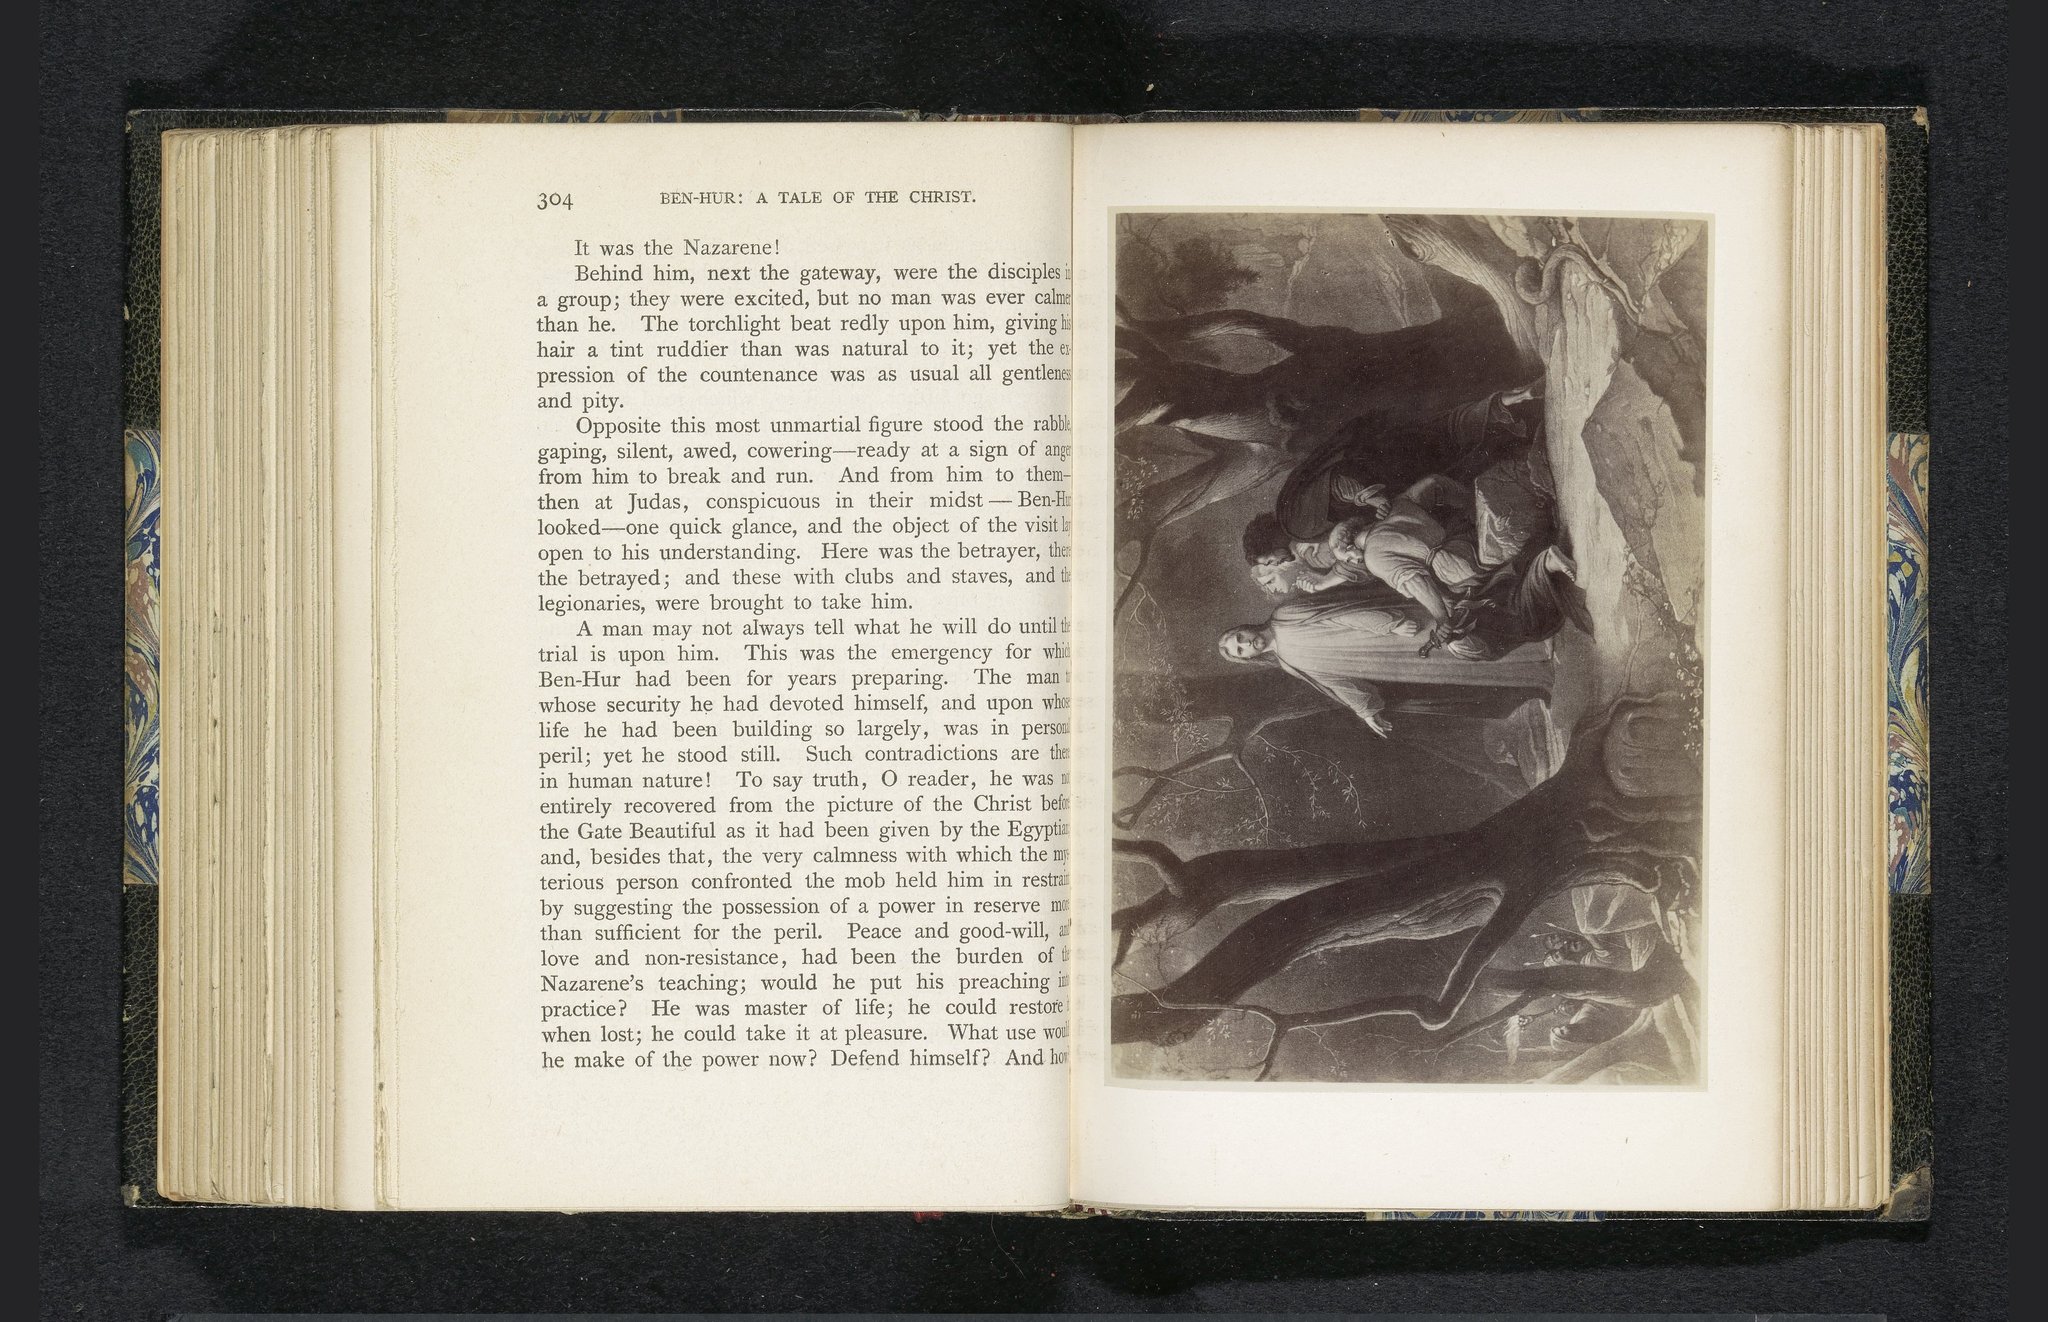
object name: photograph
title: Fotoreproductie van een schilderij, voorstellende Christus en zijn discipelen in de Hof van Getsemane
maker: Anonymous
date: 1883-1888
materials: photographic support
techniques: albumen print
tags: the arrest of christ ~ garden of gethsemane